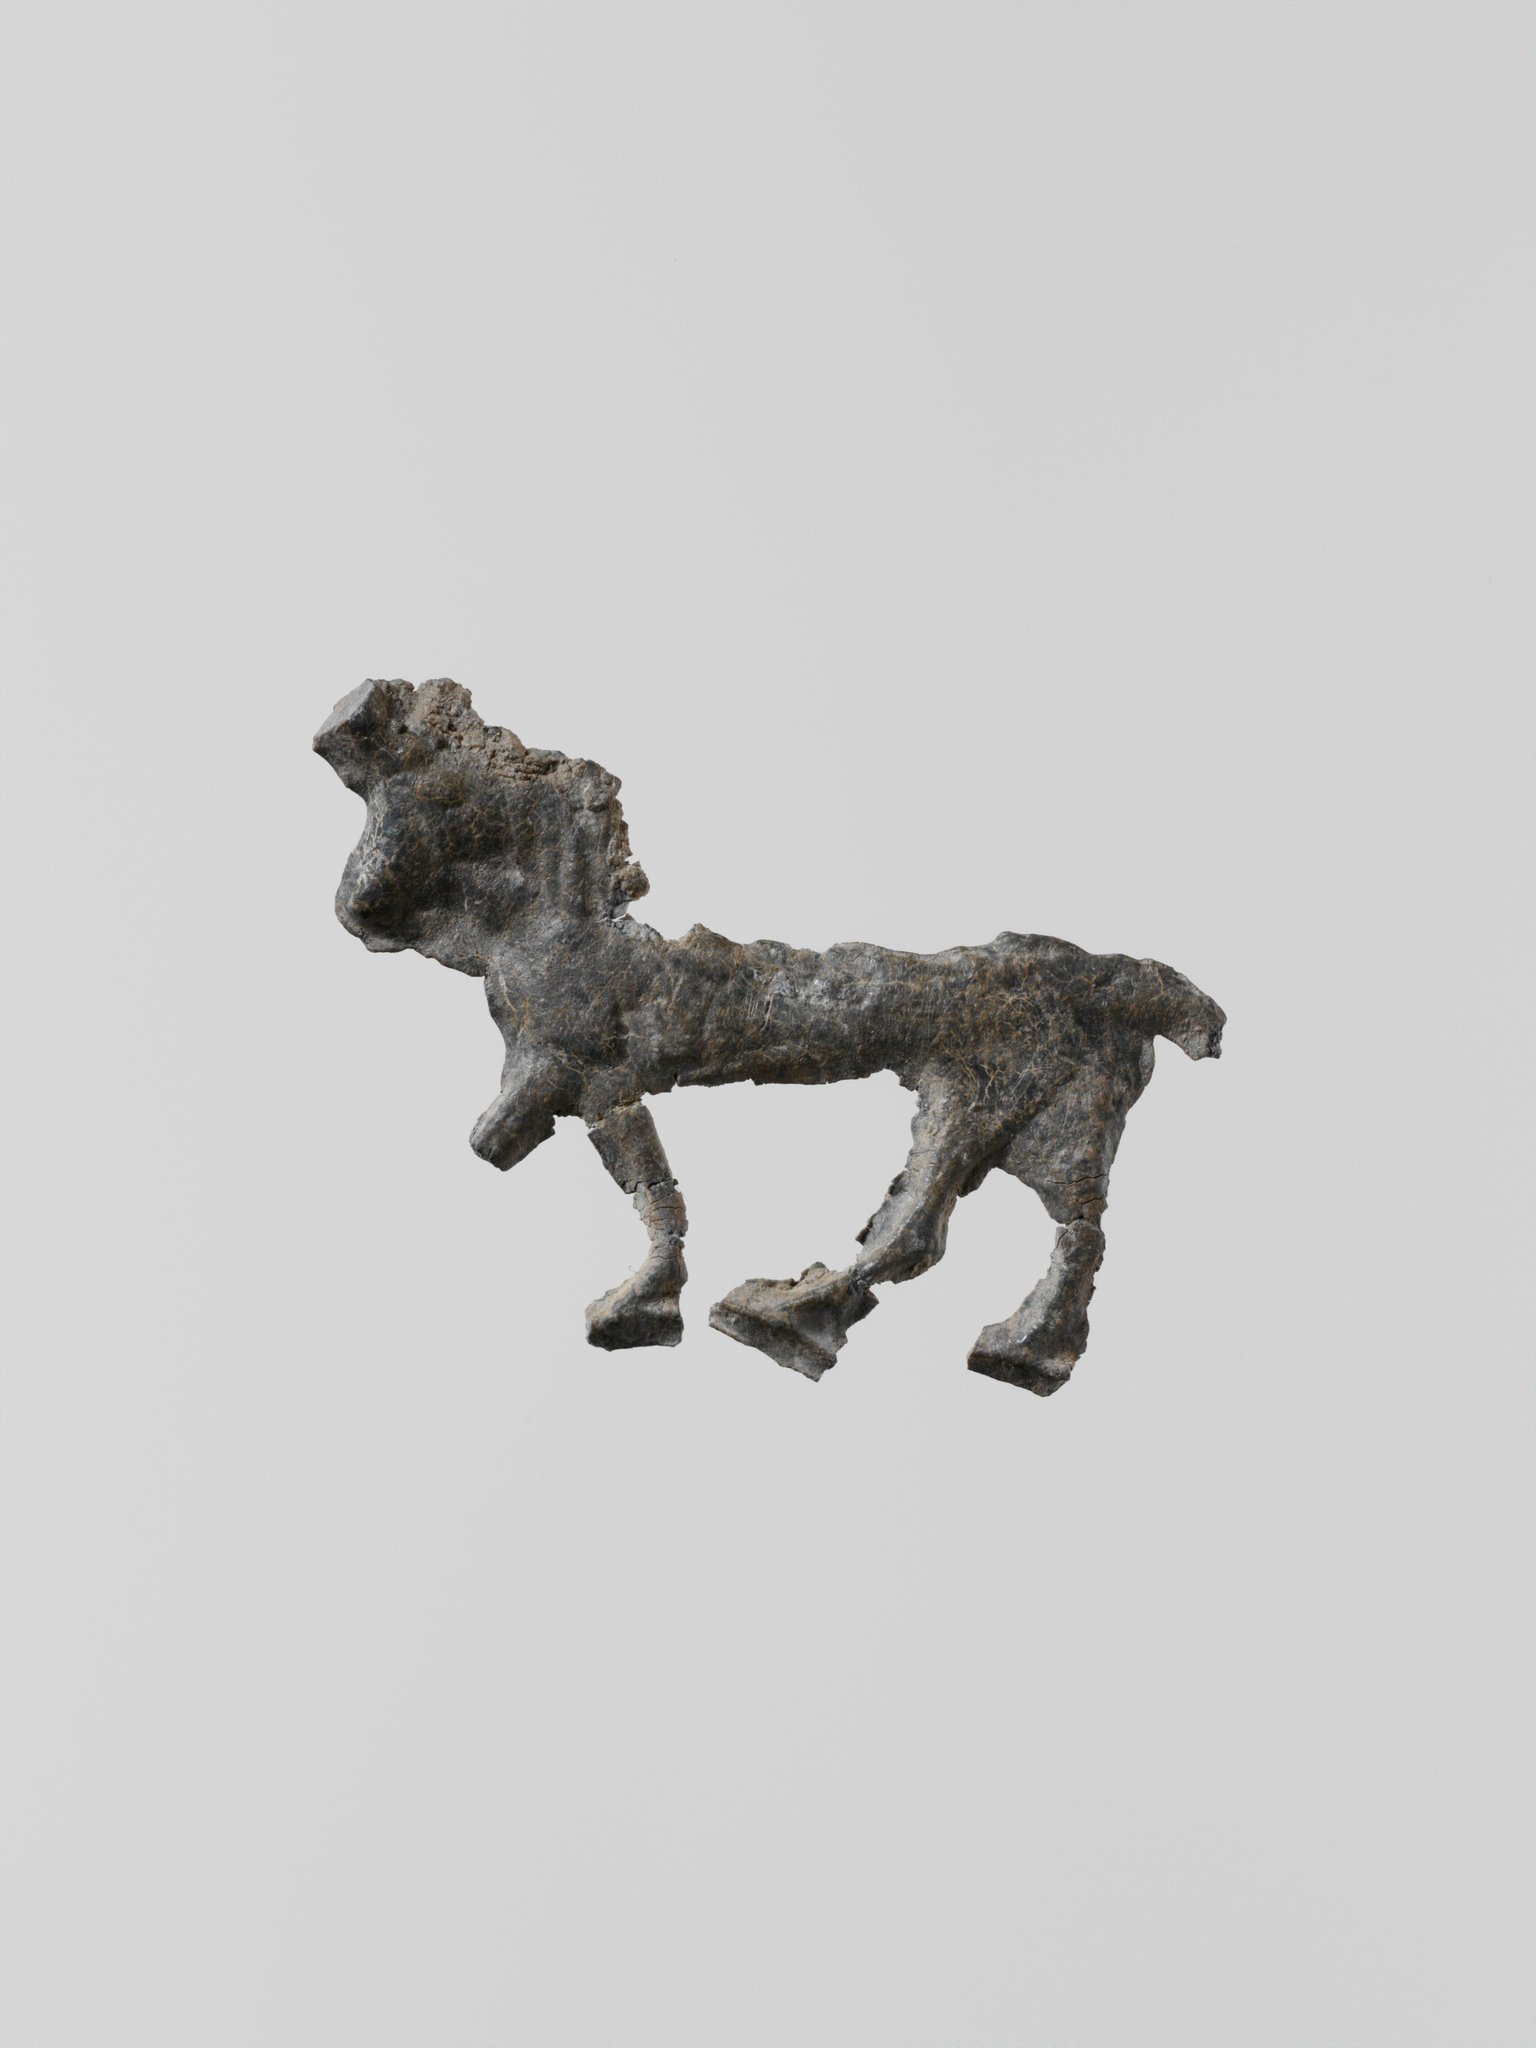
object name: statuette of a horse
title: Statuette of a horse, 3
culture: greek, laconian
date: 7000-30 BCE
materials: lead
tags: horses